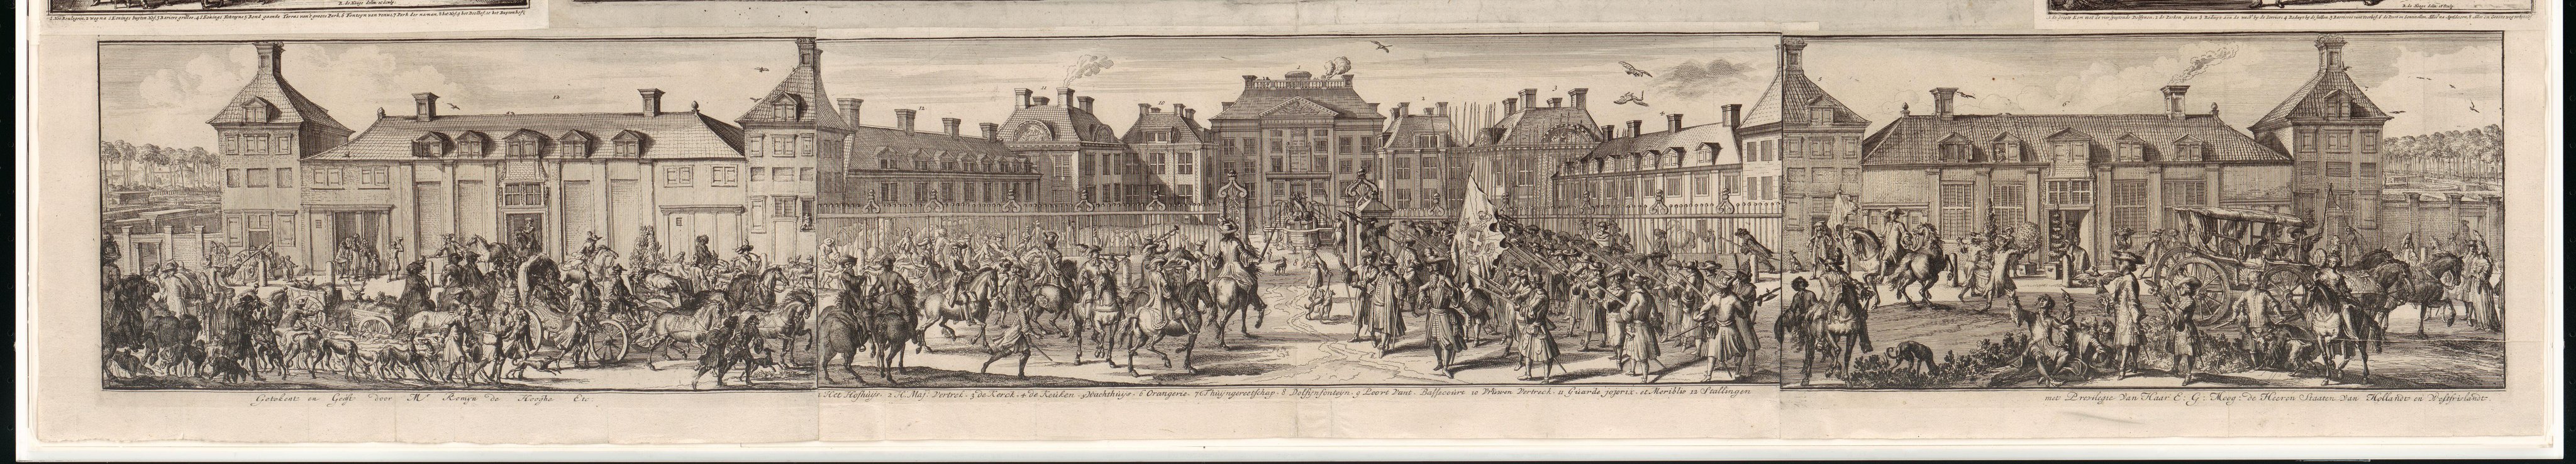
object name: print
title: Gezichten op Paleis Het Loo, de bijbehorende gebouwen en het bijbehorende park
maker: romeyn de hooghe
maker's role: draughtsman, goldsmith, painter, print maker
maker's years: 1645-1708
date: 1690-1694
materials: paper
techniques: etching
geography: haarlem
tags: william iii (prince of orange and king of england, scotland, and ireland), sports, games ~ animals (+ hunting with falcon, hawk; falconry), four-wheeled, animal-drawn vehicle, e.g.: cab, carriage, coach, palace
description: Gezicht (over 3 bladen) op Paleis Het Loo, met valkeniers, ruiters, koetsen en voornaam geklede mannen en vrouwen ervoor. In de marge onder de voorstelling een legenda in het Nederlands. Deze bladen maken deel uit van een omvangrijke prent met een gezicht op Paleis Het Loo, omgeven door dertien gezichten op de bijbehorende gebouwen en het bijbehorende park (boven, links, rechts), en een profiel van het paleis (onder).